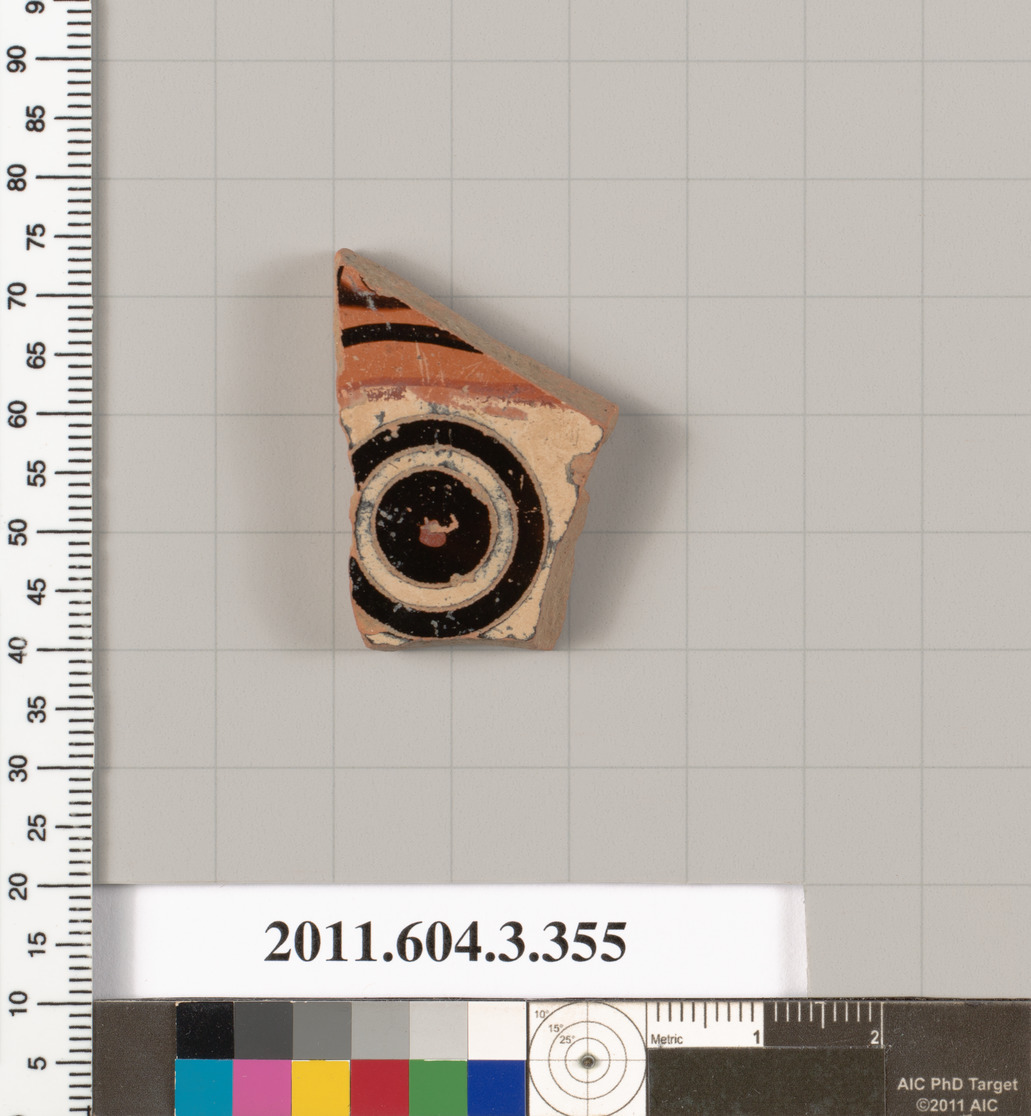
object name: neck amphora fragment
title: Terracotta fragment of a neck-amphora (jar)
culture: greek, attic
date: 525-501 BCE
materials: terracotta